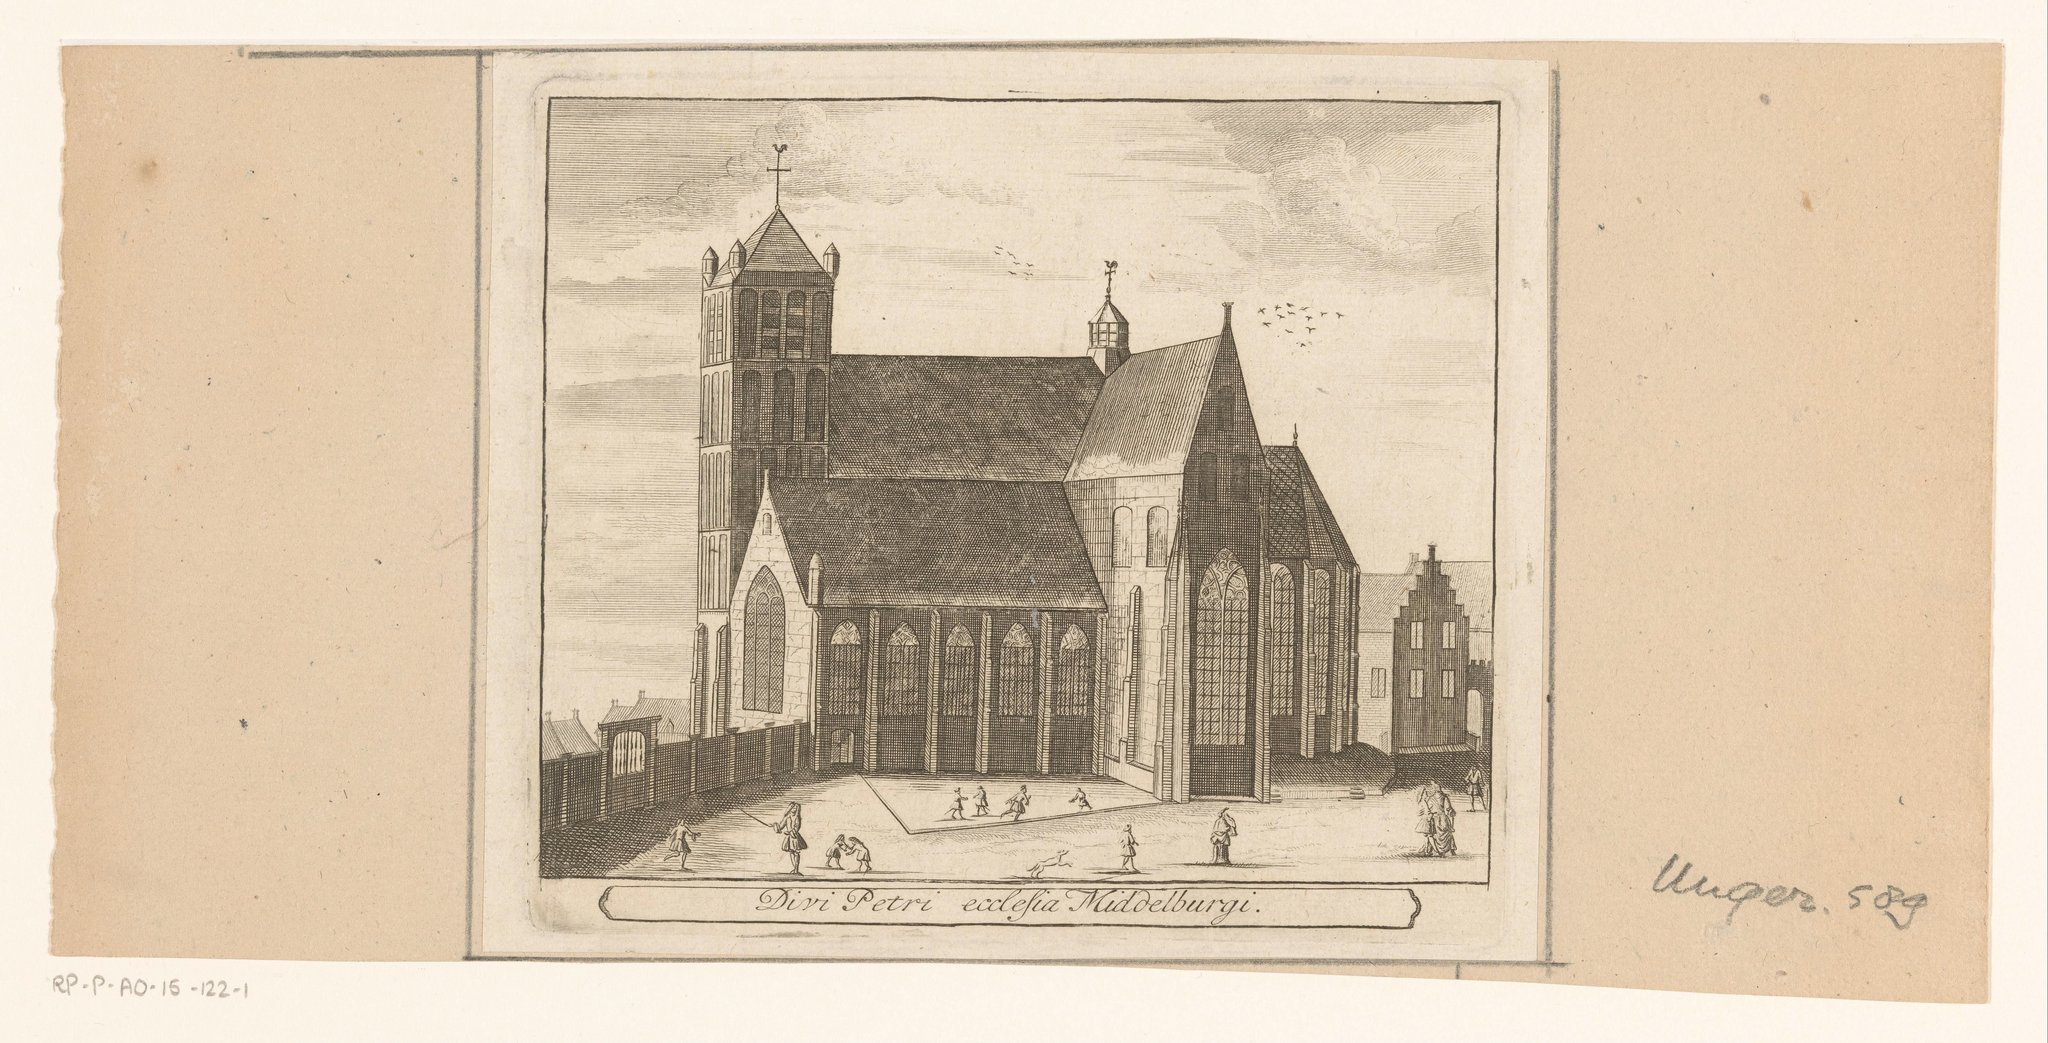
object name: book illustration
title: Gezicht op de Noordmonsterkerk te Middelburg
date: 1722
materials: paper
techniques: engraving, etching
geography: leiden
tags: church (exterior)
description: Prent ook gebruikt in: Heussen, Hugo Franciscus van. Oudheden en gestichten van Zeeland (…). 2 delen. Leiden: Christiaan Vermey, 1722, dl. 1.